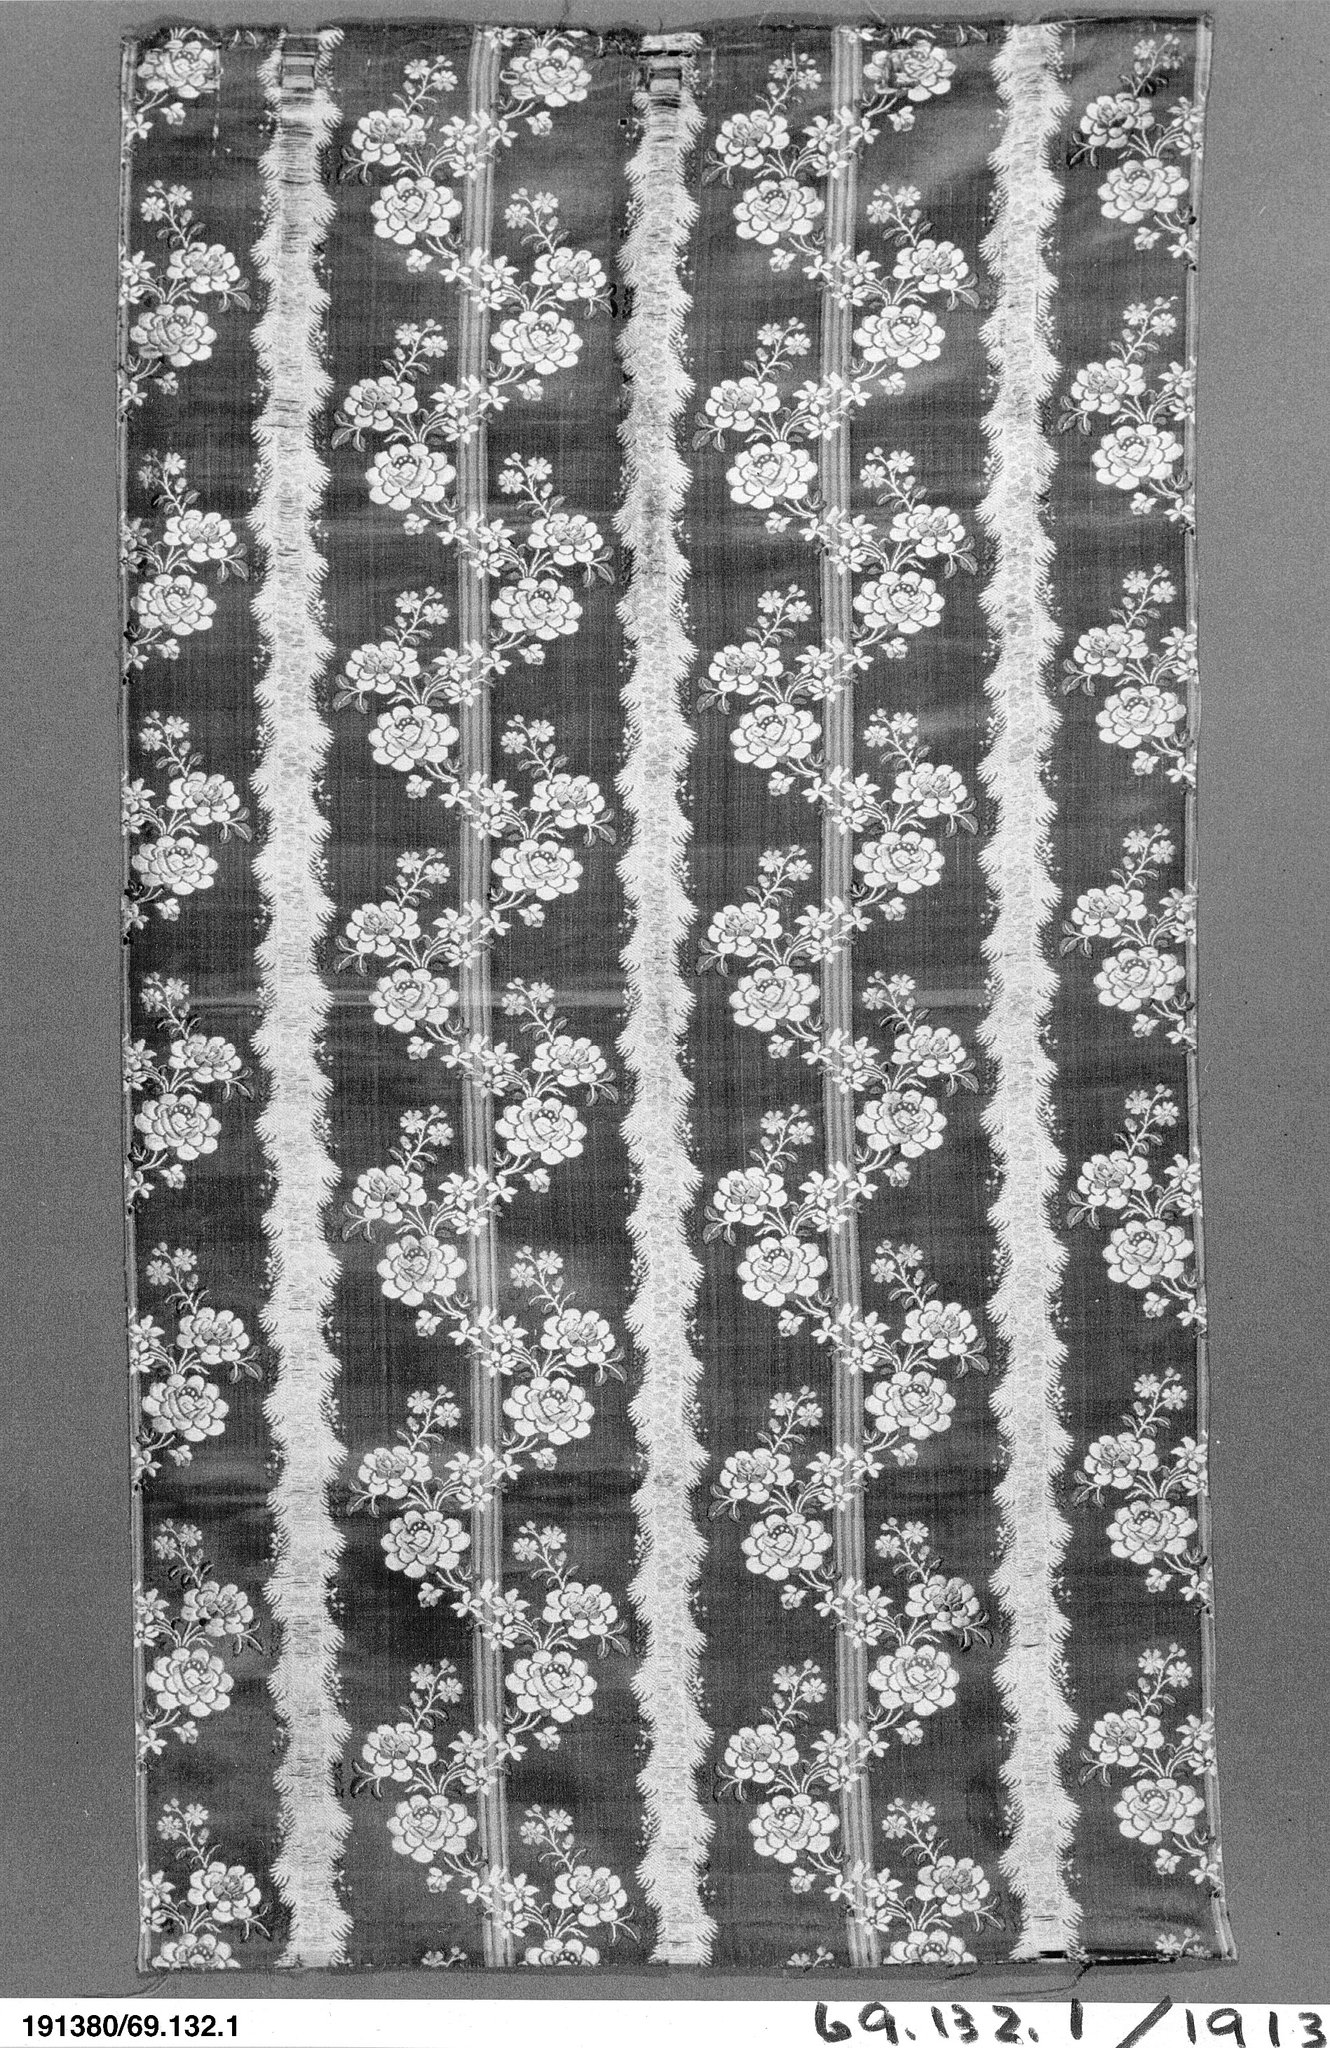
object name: panel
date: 1765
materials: silk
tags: flowers,leaves